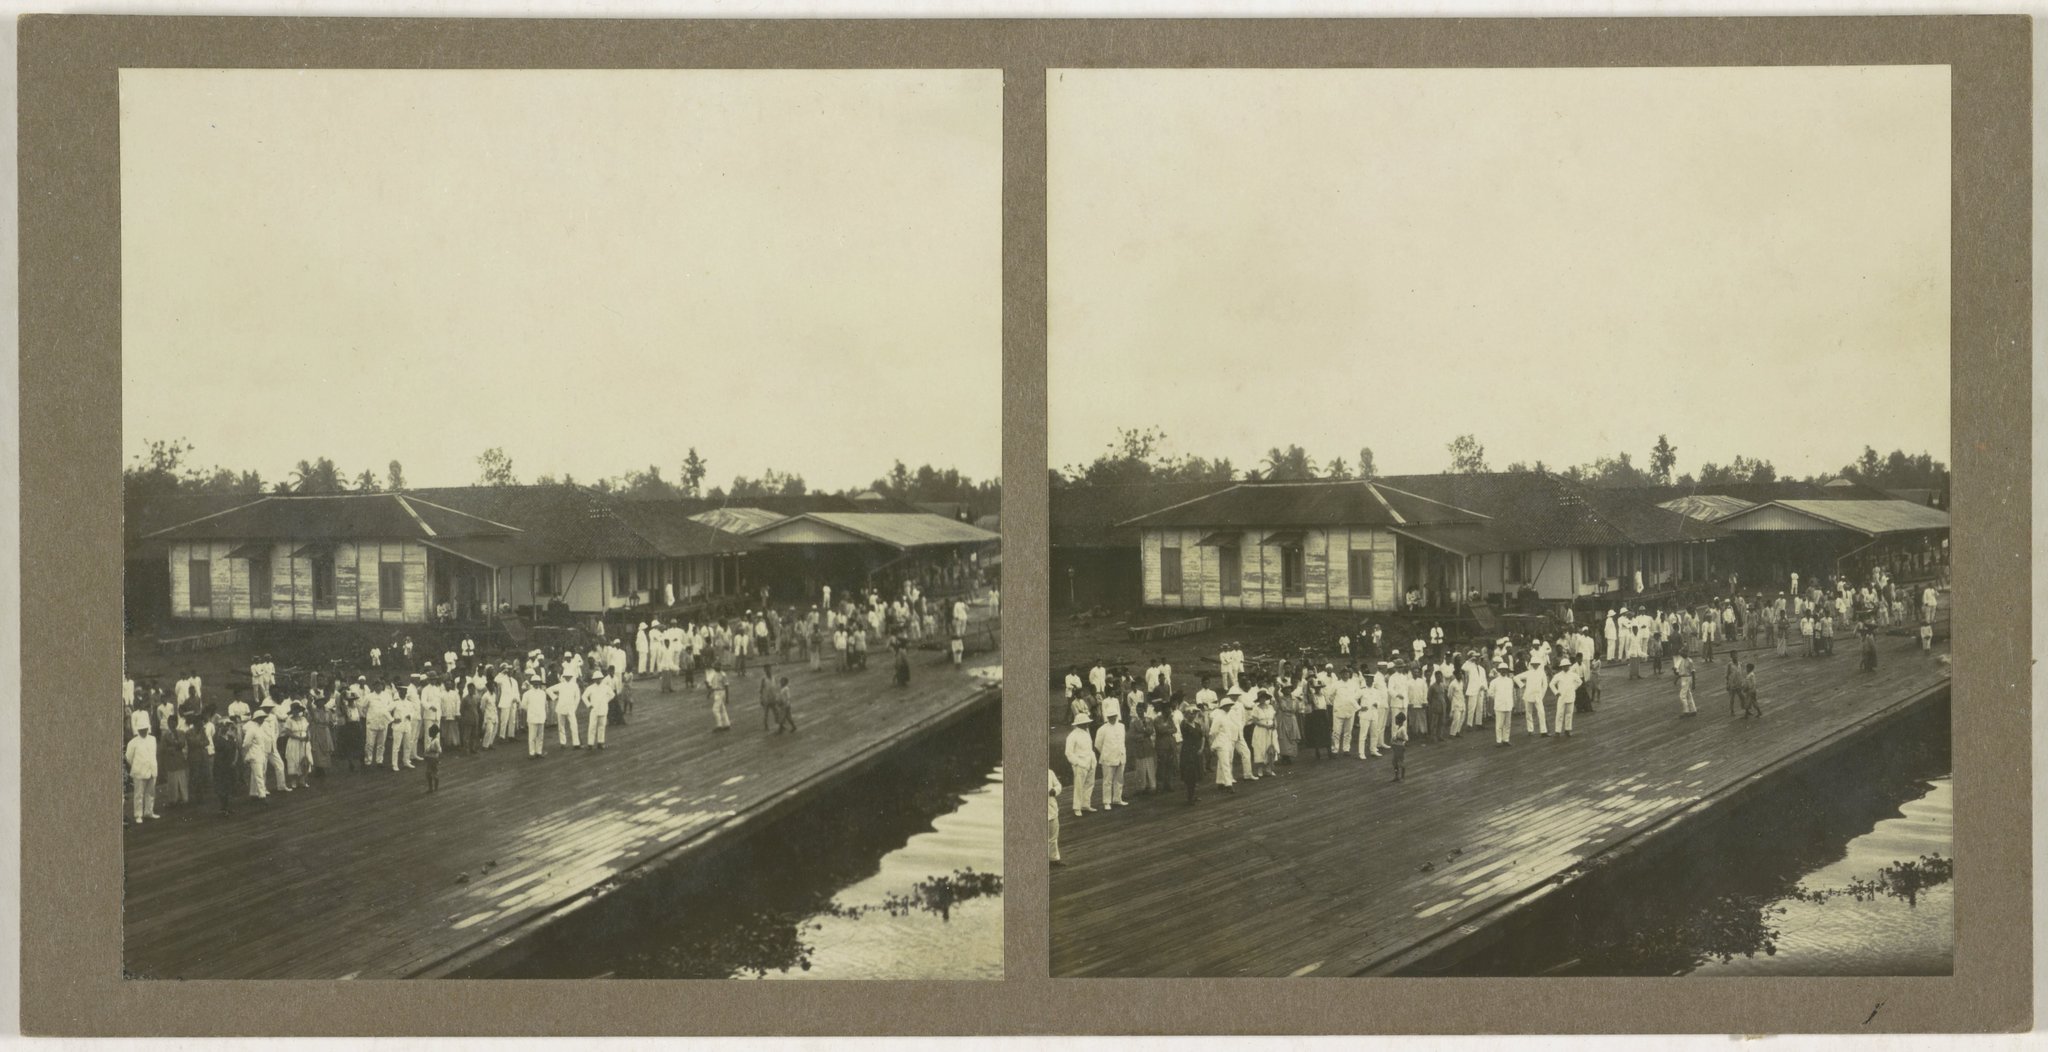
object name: stereograph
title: Menigte mensen op een houten kade, mogelijk op Borneo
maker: Anonymous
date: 1900-1940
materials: paper, cardboard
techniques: gelatin silver print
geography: indonesia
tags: quay, indonesia